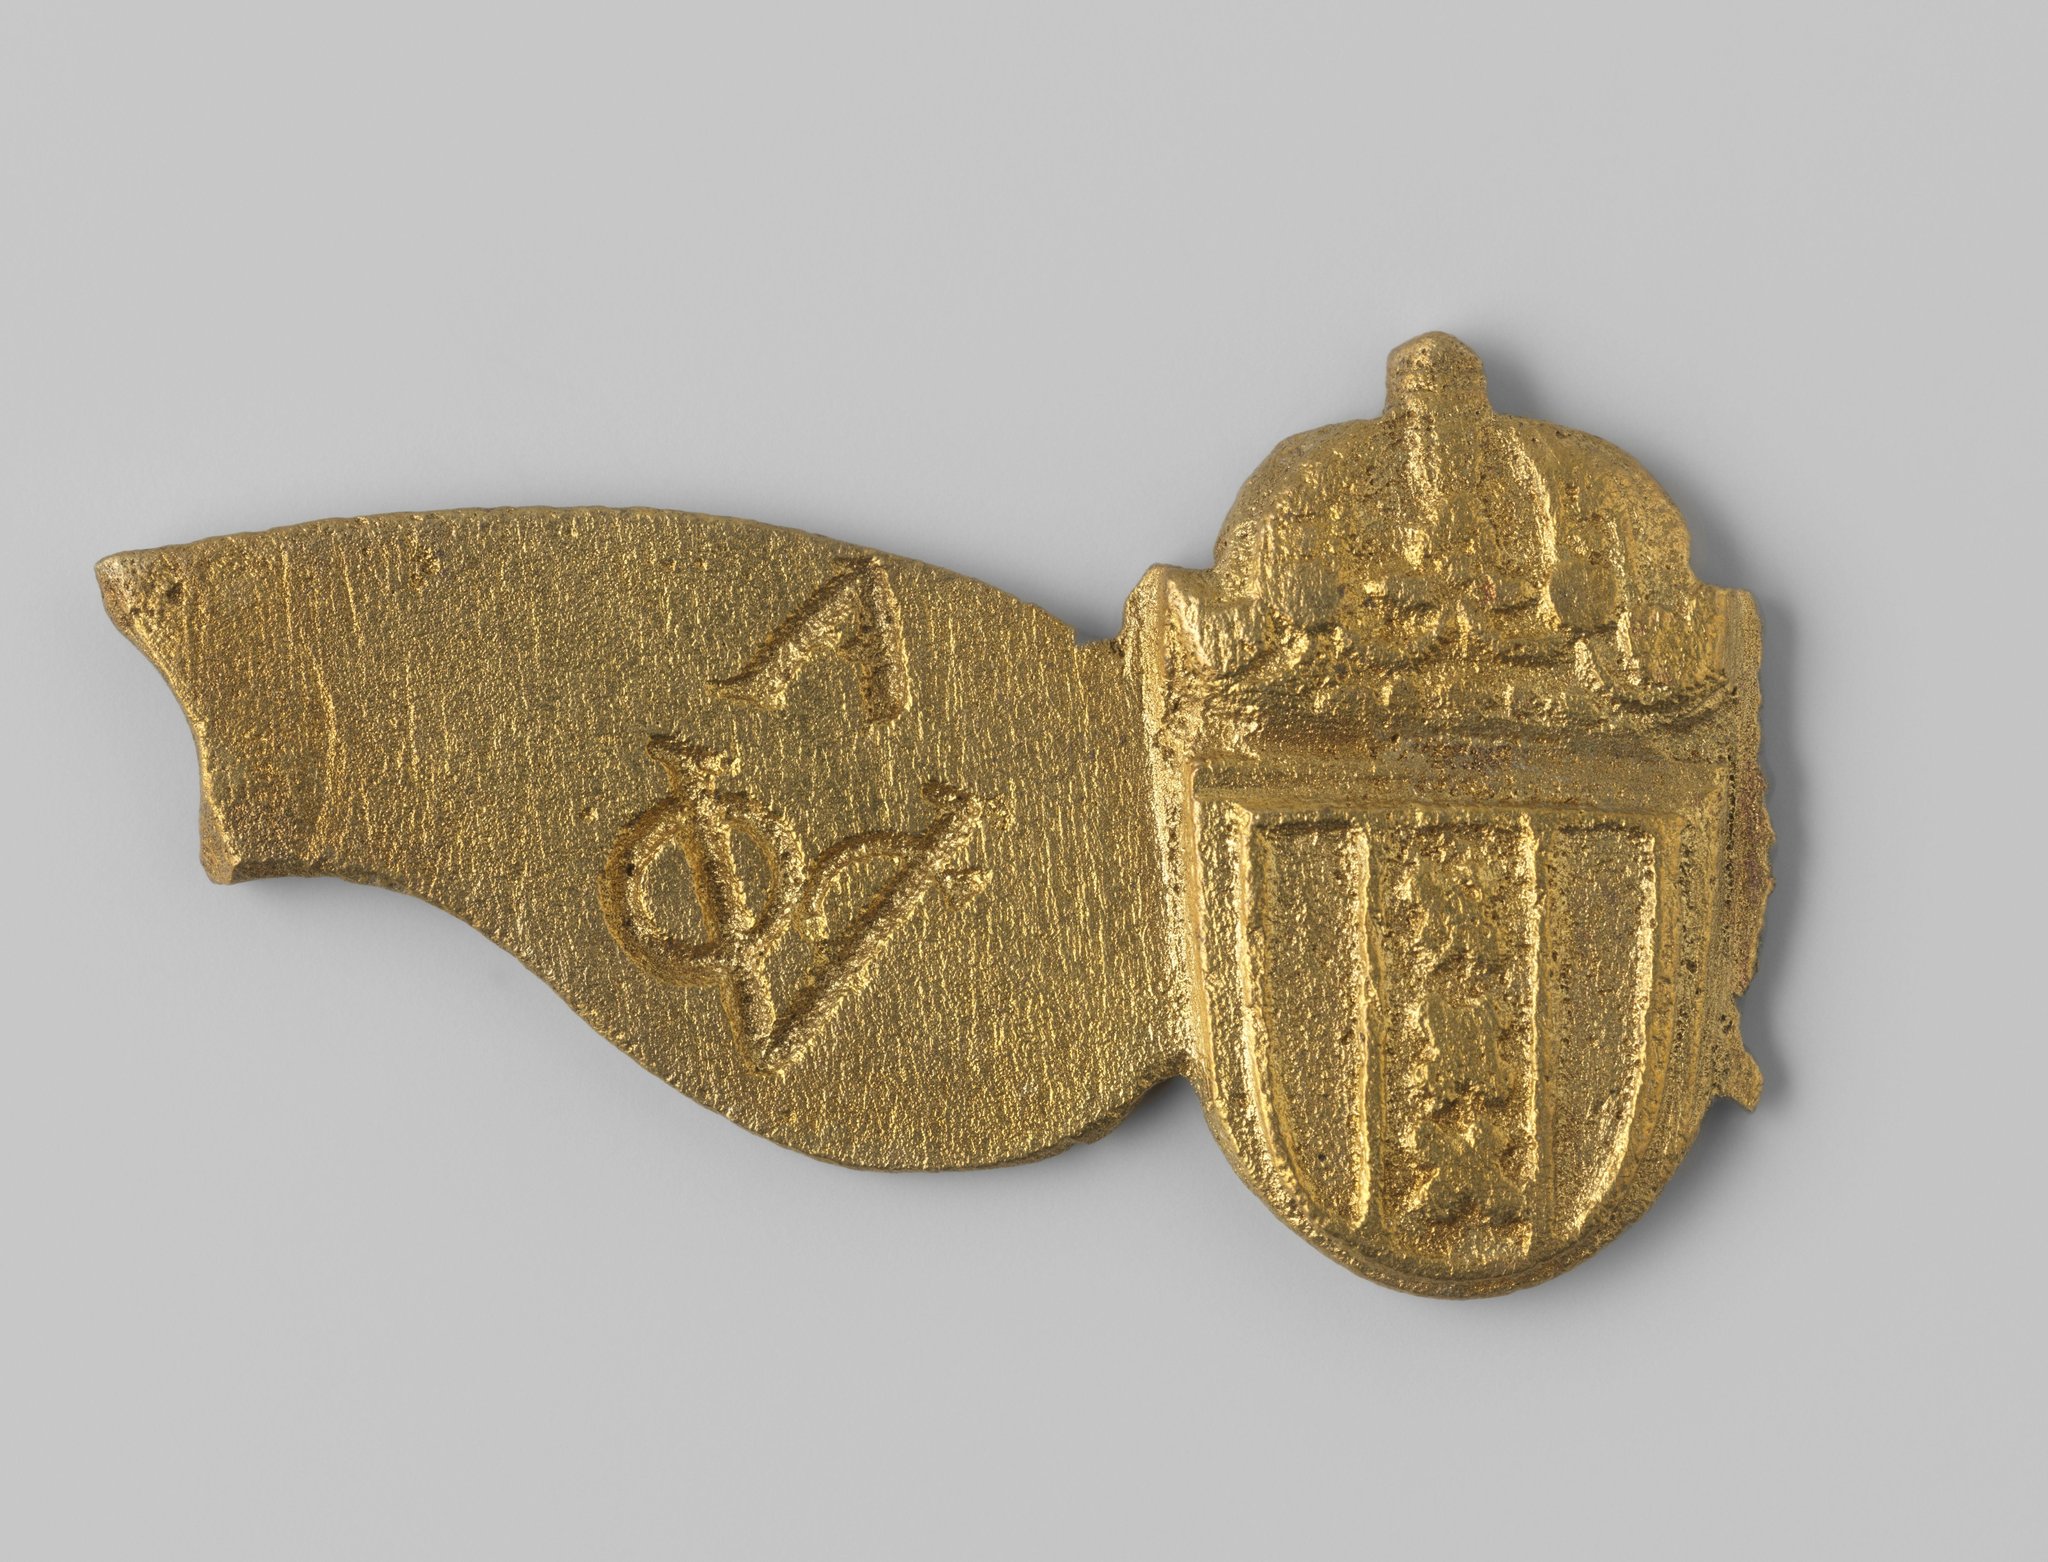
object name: schroefplaat, schroefblik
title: Fragment schroefplaat van een musket uit het wrak van de Oost-Indiëvaarder Hollandia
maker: Anonymous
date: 1700-1743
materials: copper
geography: netherlands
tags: verenigde oostindische compagnie, hollandia (schip), annet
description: Fragm, id. NG 1980-27H3069, right wing broken off, side plate.